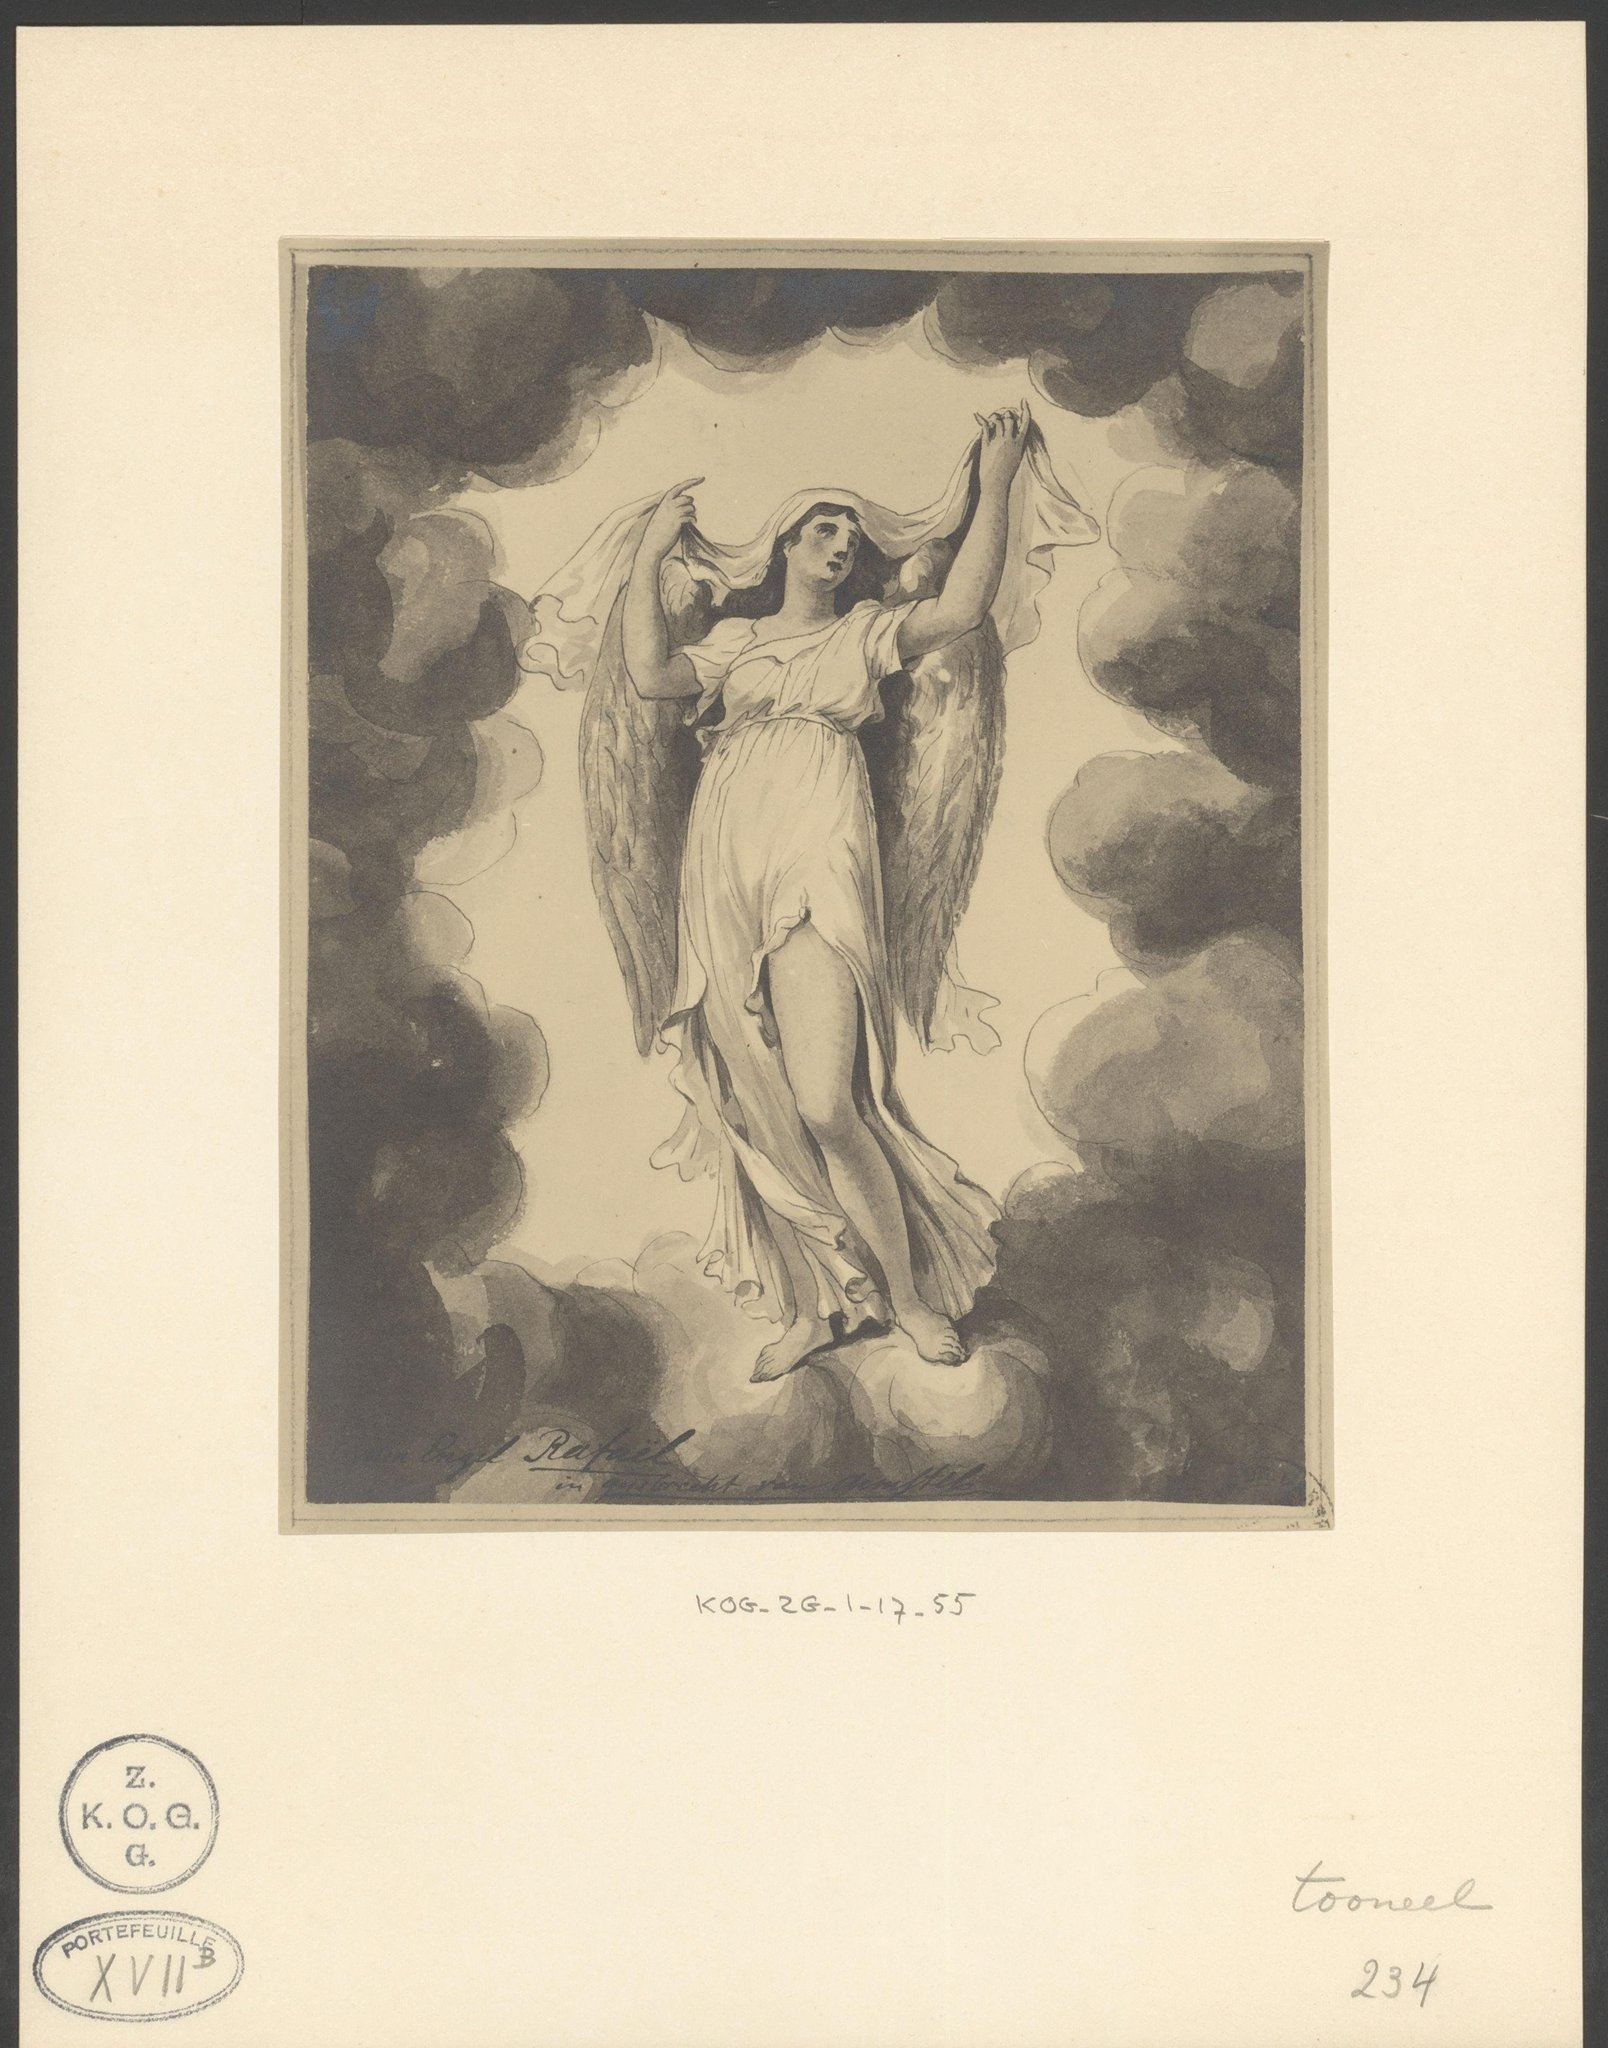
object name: photograph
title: Engel Rafaël uit de Gijsbrecht van Amstel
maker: Anonymous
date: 1900-1949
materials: paper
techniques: gelatin silver print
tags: female angels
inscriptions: collector's mark: Lugt 1641, stamp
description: Onderwerpsrubrieken binnen de Atlas Zeden en Gewoonten: Tooneel, Scènes en figuren uit bekende toneelspellen.